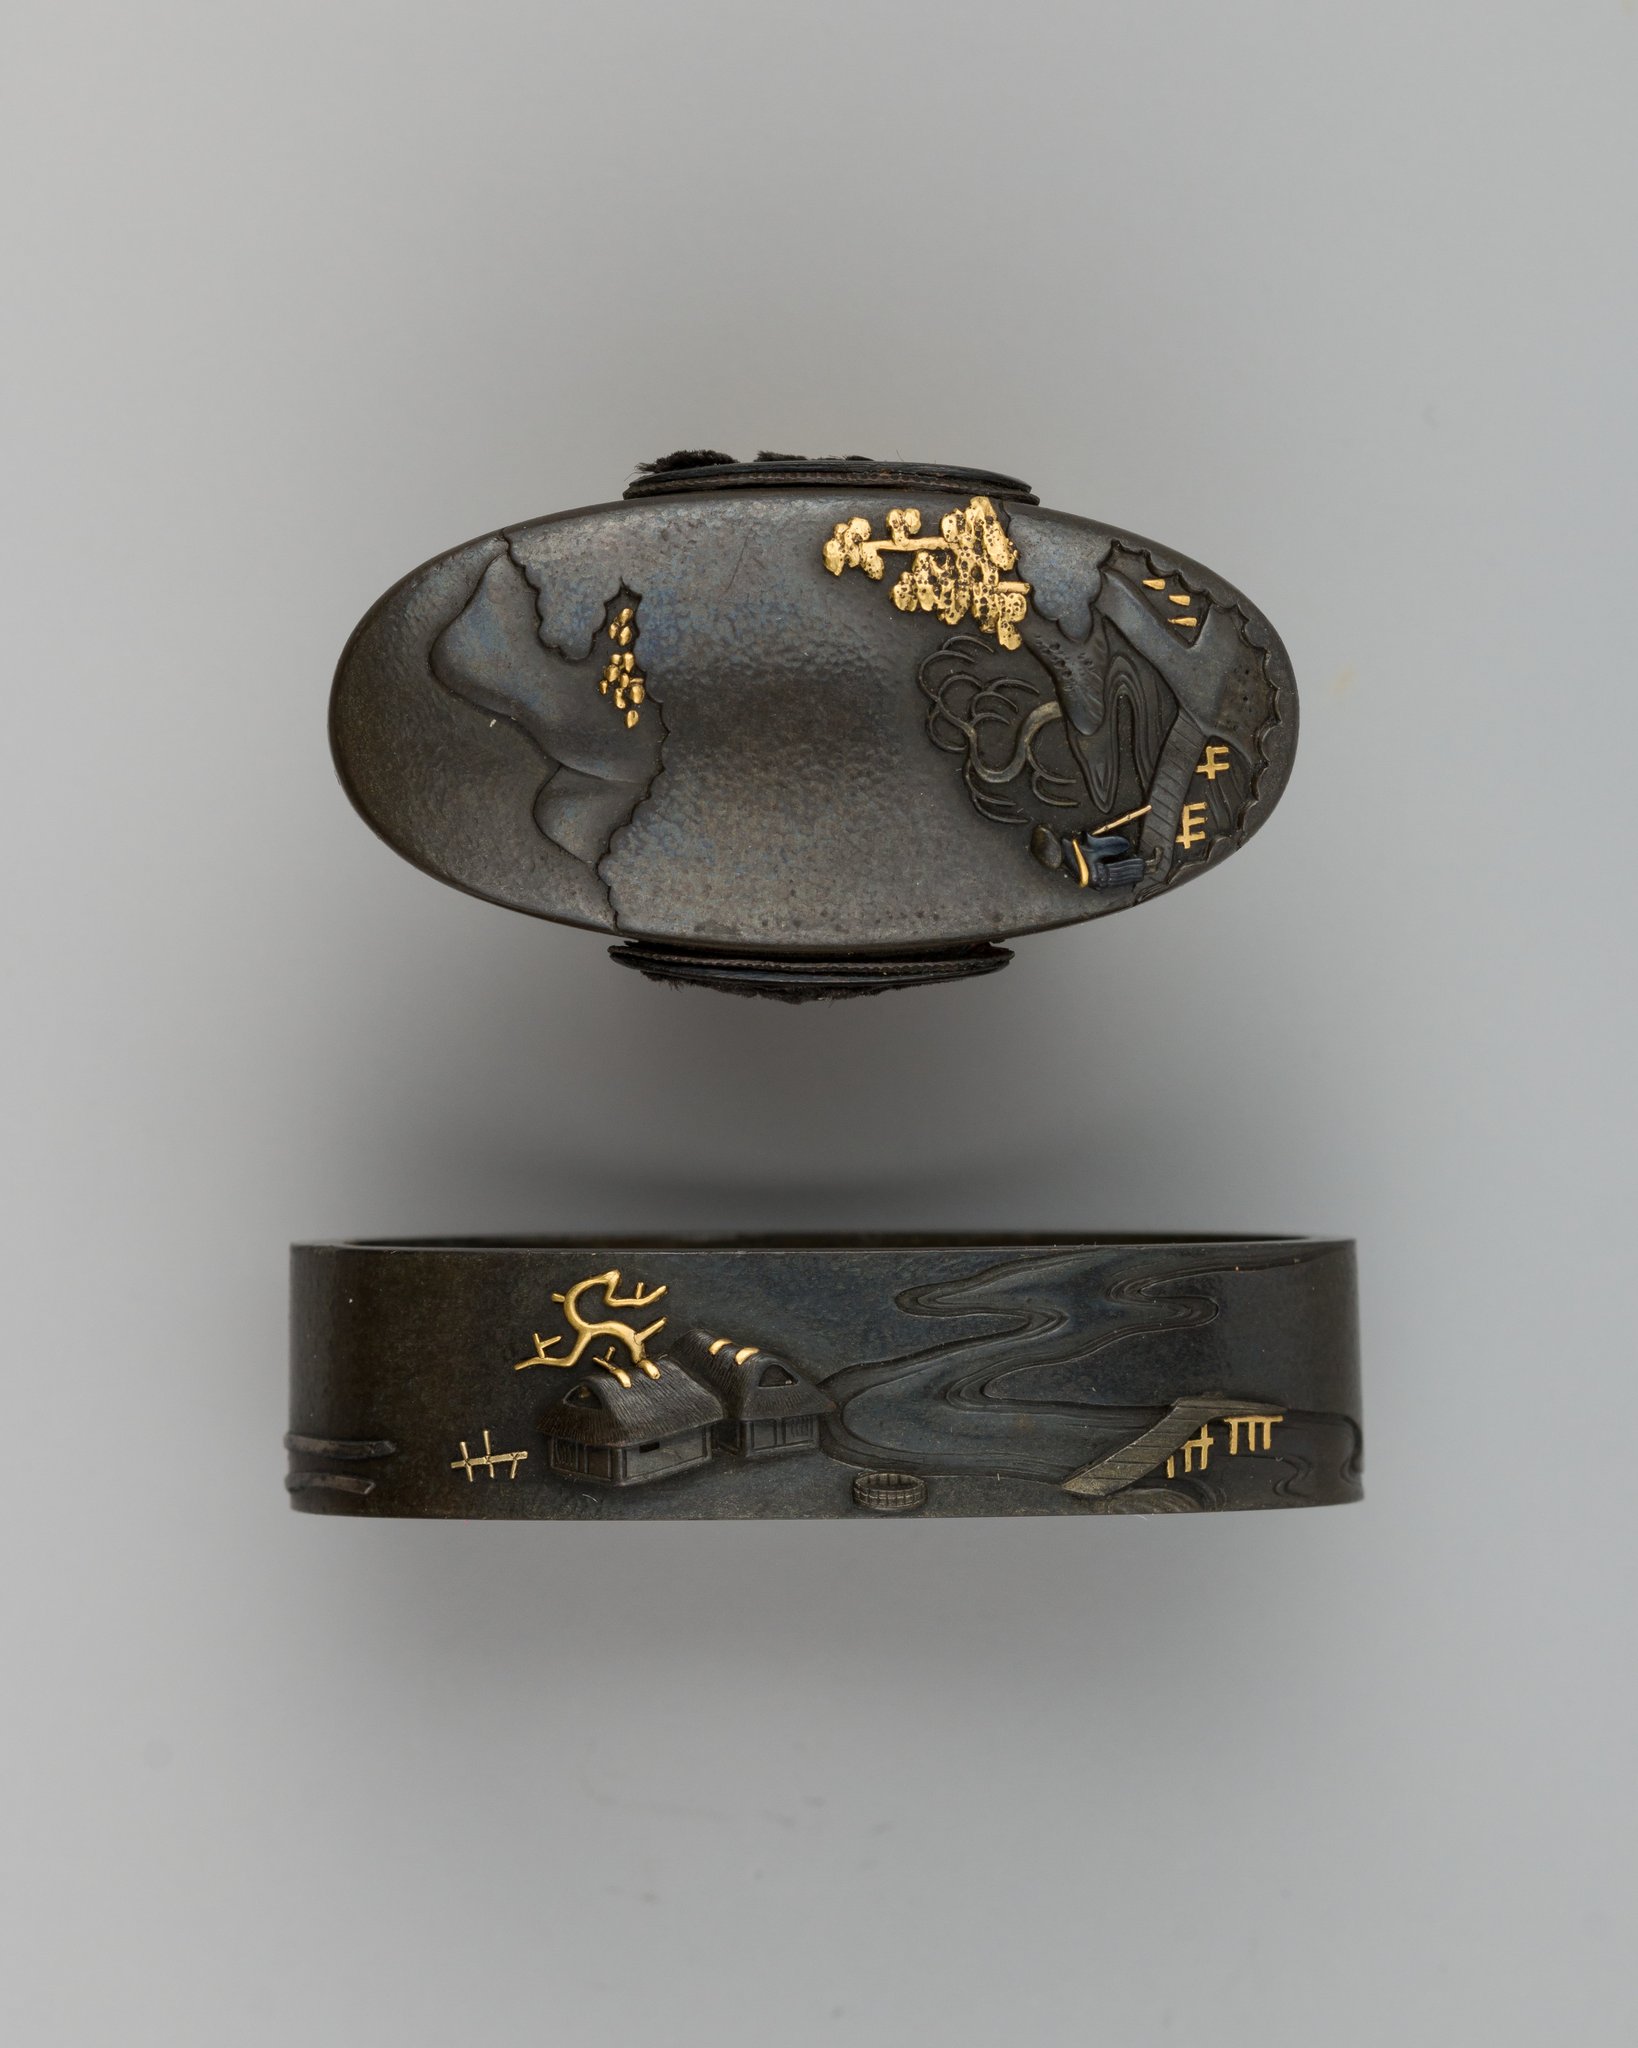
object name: sword hilt collar and pommel fuchigashira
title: Sword-Hilt Collar and Pommel (Fuchigashira)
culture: japanese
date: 1615-1868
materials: silver alloy, gold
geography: japan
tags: houses